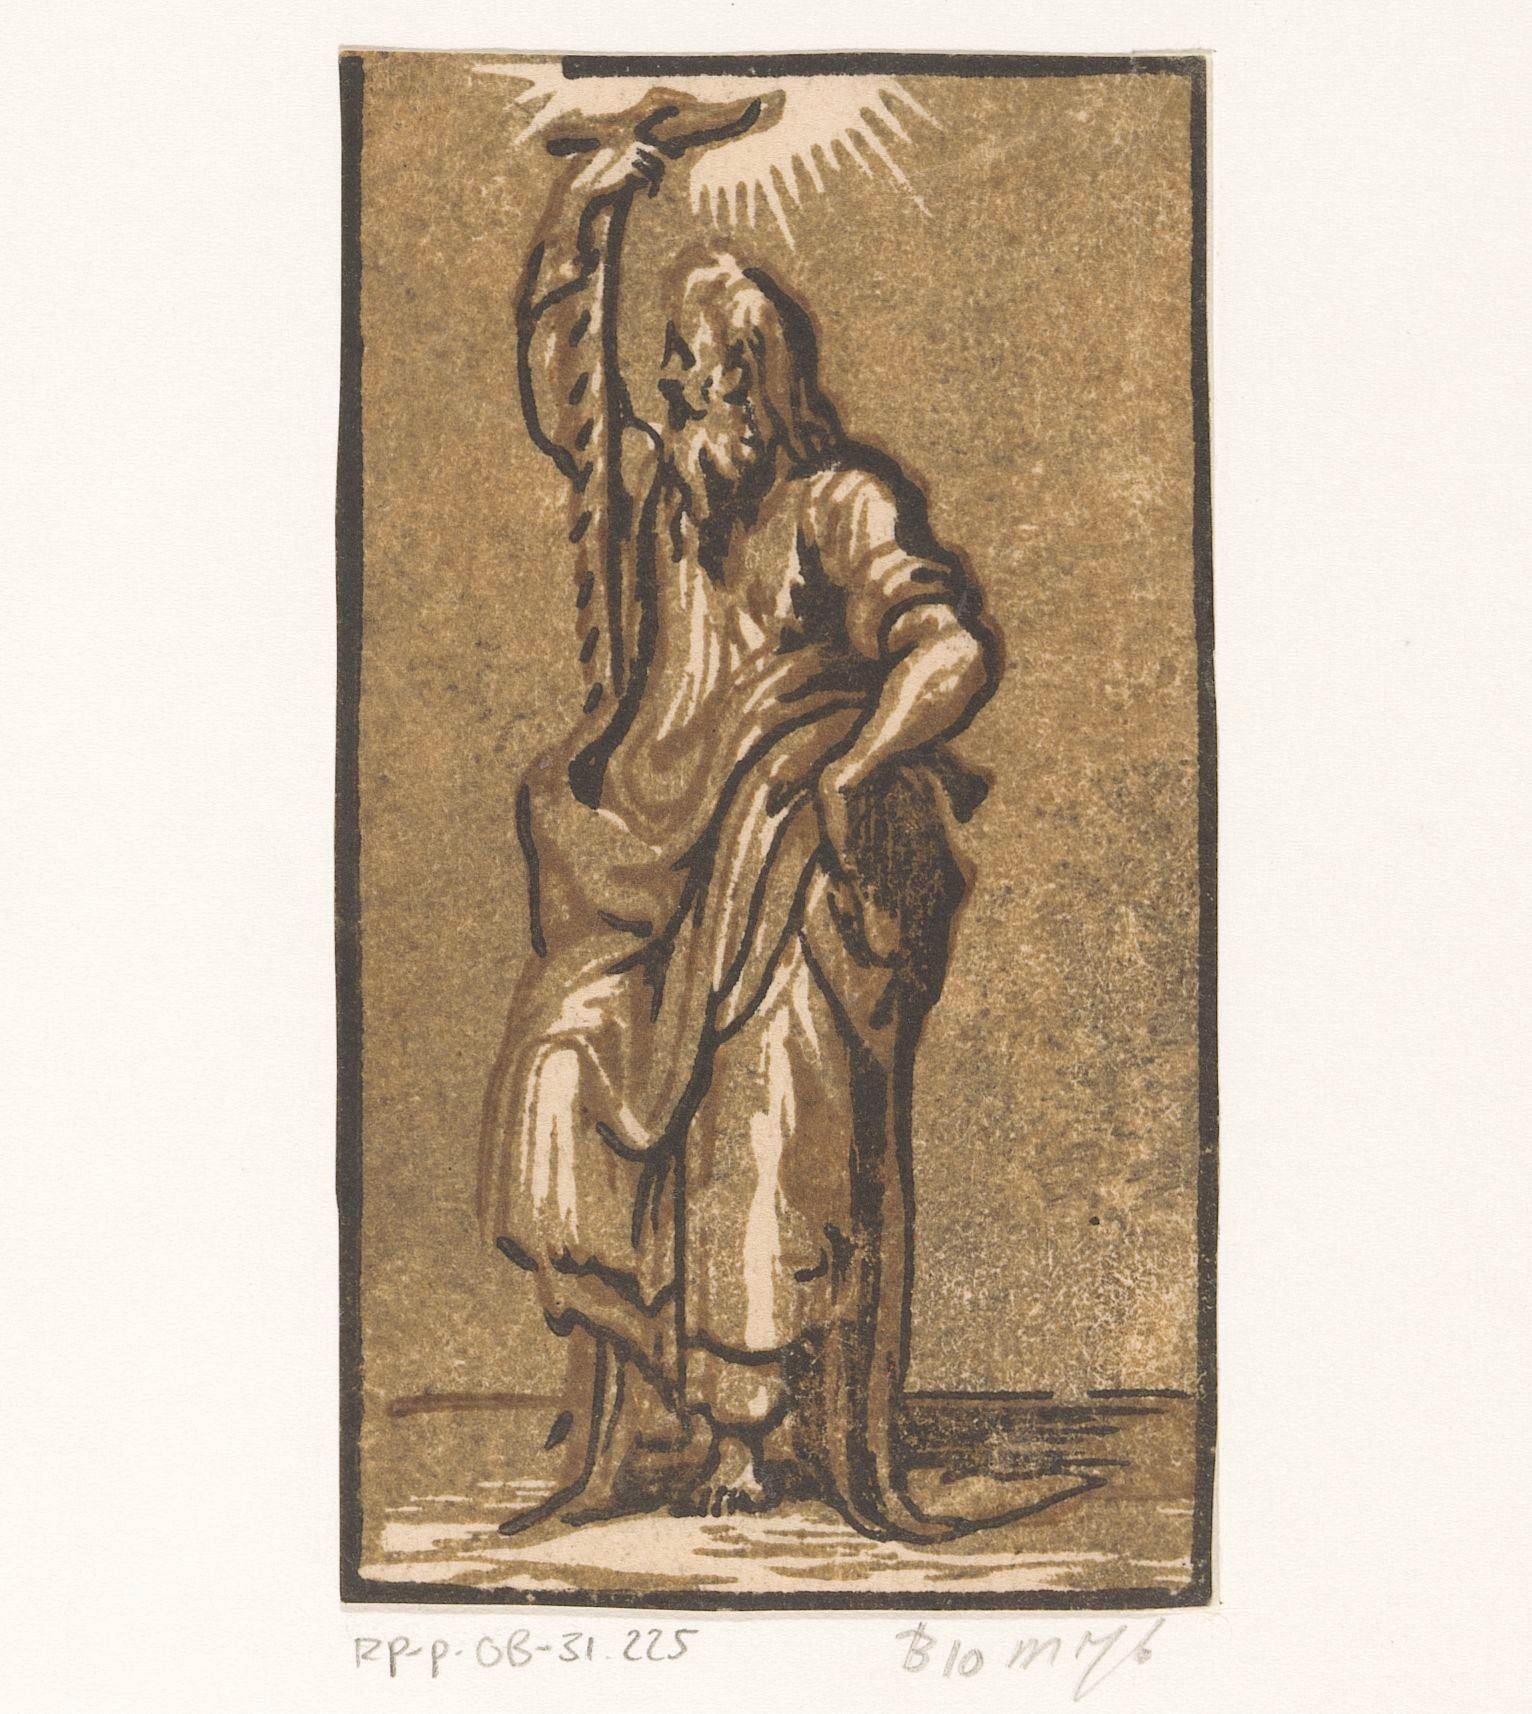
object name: print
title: Christus en de twaalf apostelen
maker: antonio da trento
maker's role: painter, print maker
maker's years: 1510-1550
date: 1520-1550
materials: paper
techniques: woodcut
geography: italy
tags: the apostle simon zelotes (or simon the canaanite); possible attributes: book, saw, scroll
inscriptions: collector's mark: Lugt 240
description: Deze prent maakt deel uit van een serie bestaande uit dertien prenten met Christus en de apostelen als staande figuren. De serie is incompleet.